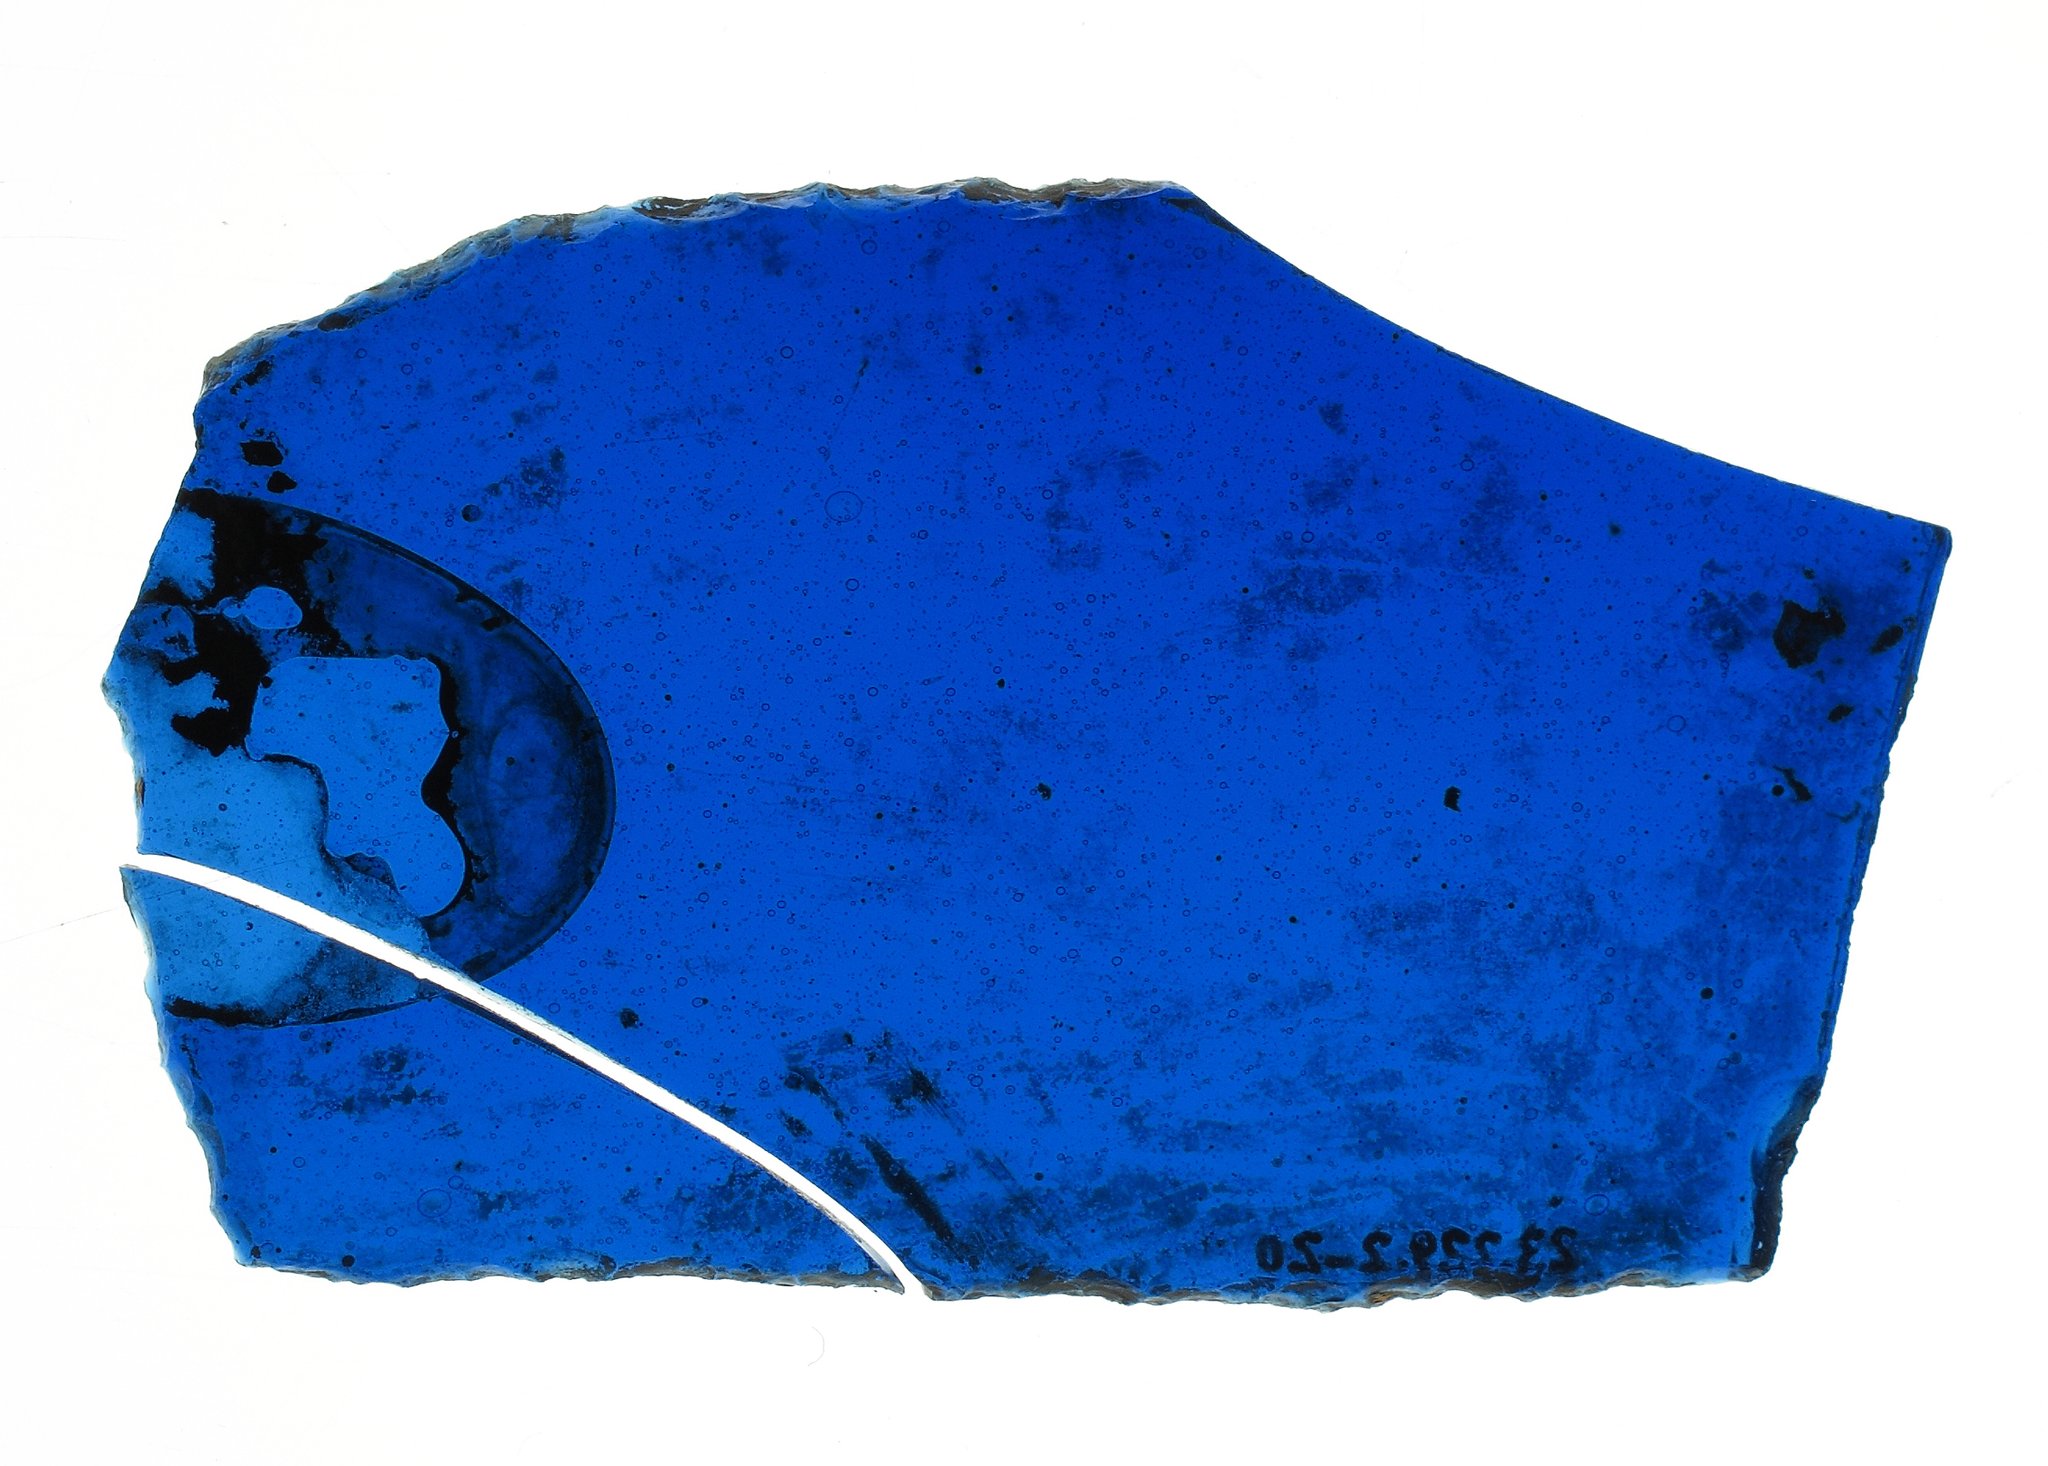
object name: fragment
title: Glass Fragment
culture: french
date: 1101-1300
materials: glass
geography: france